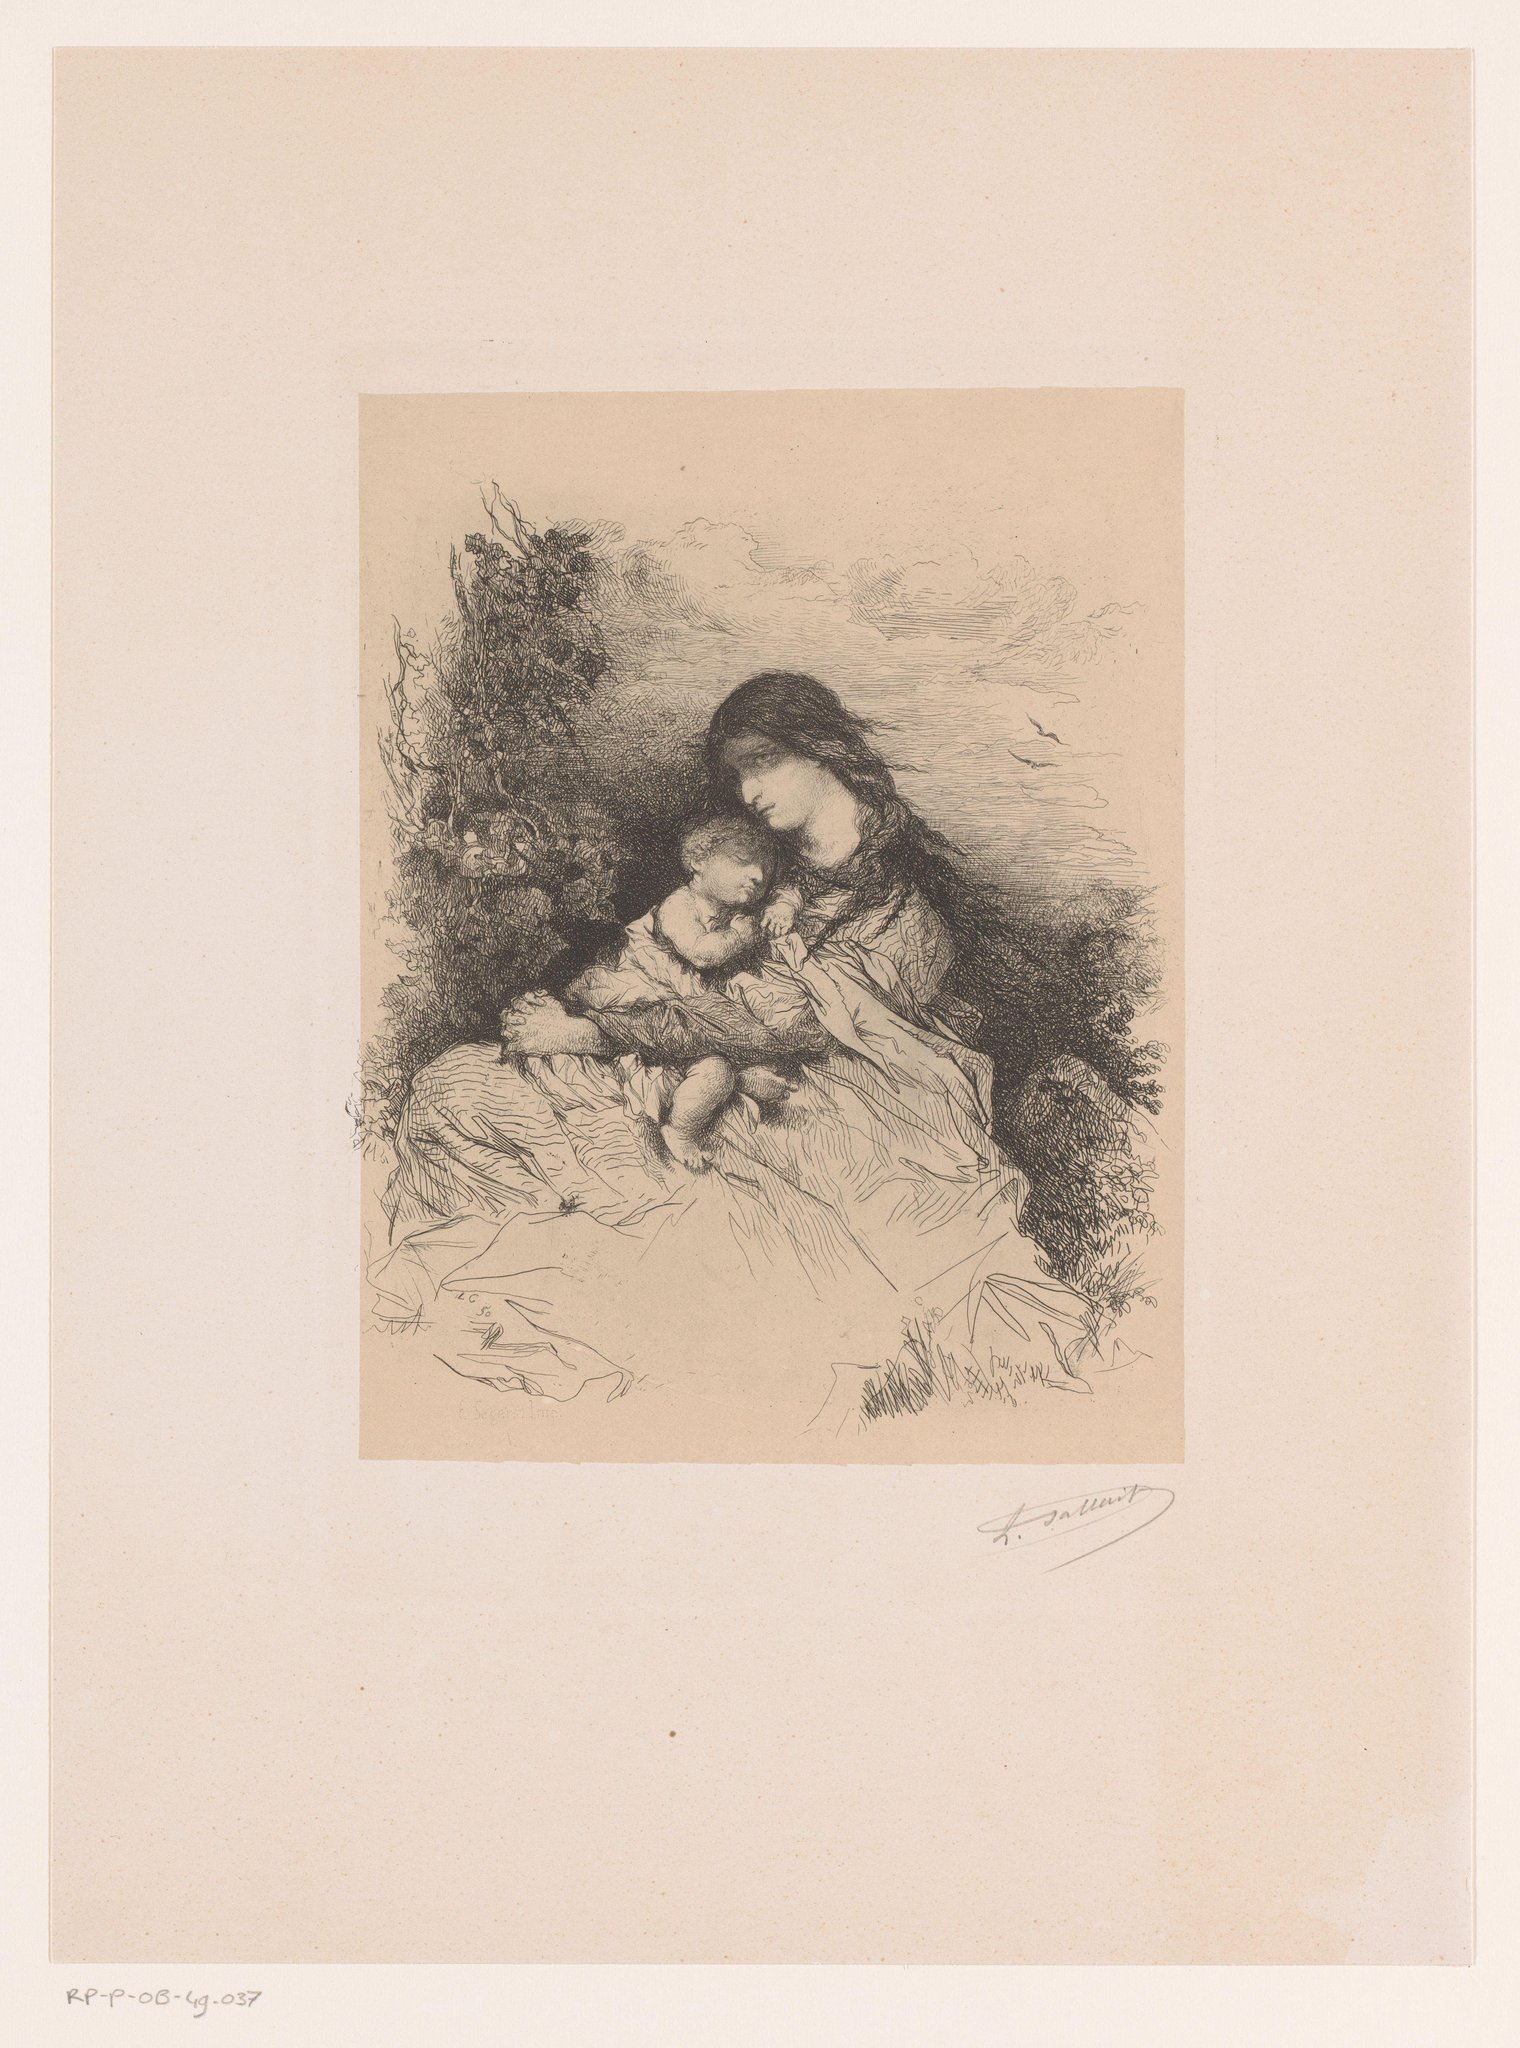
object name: print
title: Moeder met kind gezeten in een landschap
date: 1850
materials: paper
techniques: etching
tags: mother and baby or young child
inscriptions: collector's mark: Lugt 2228